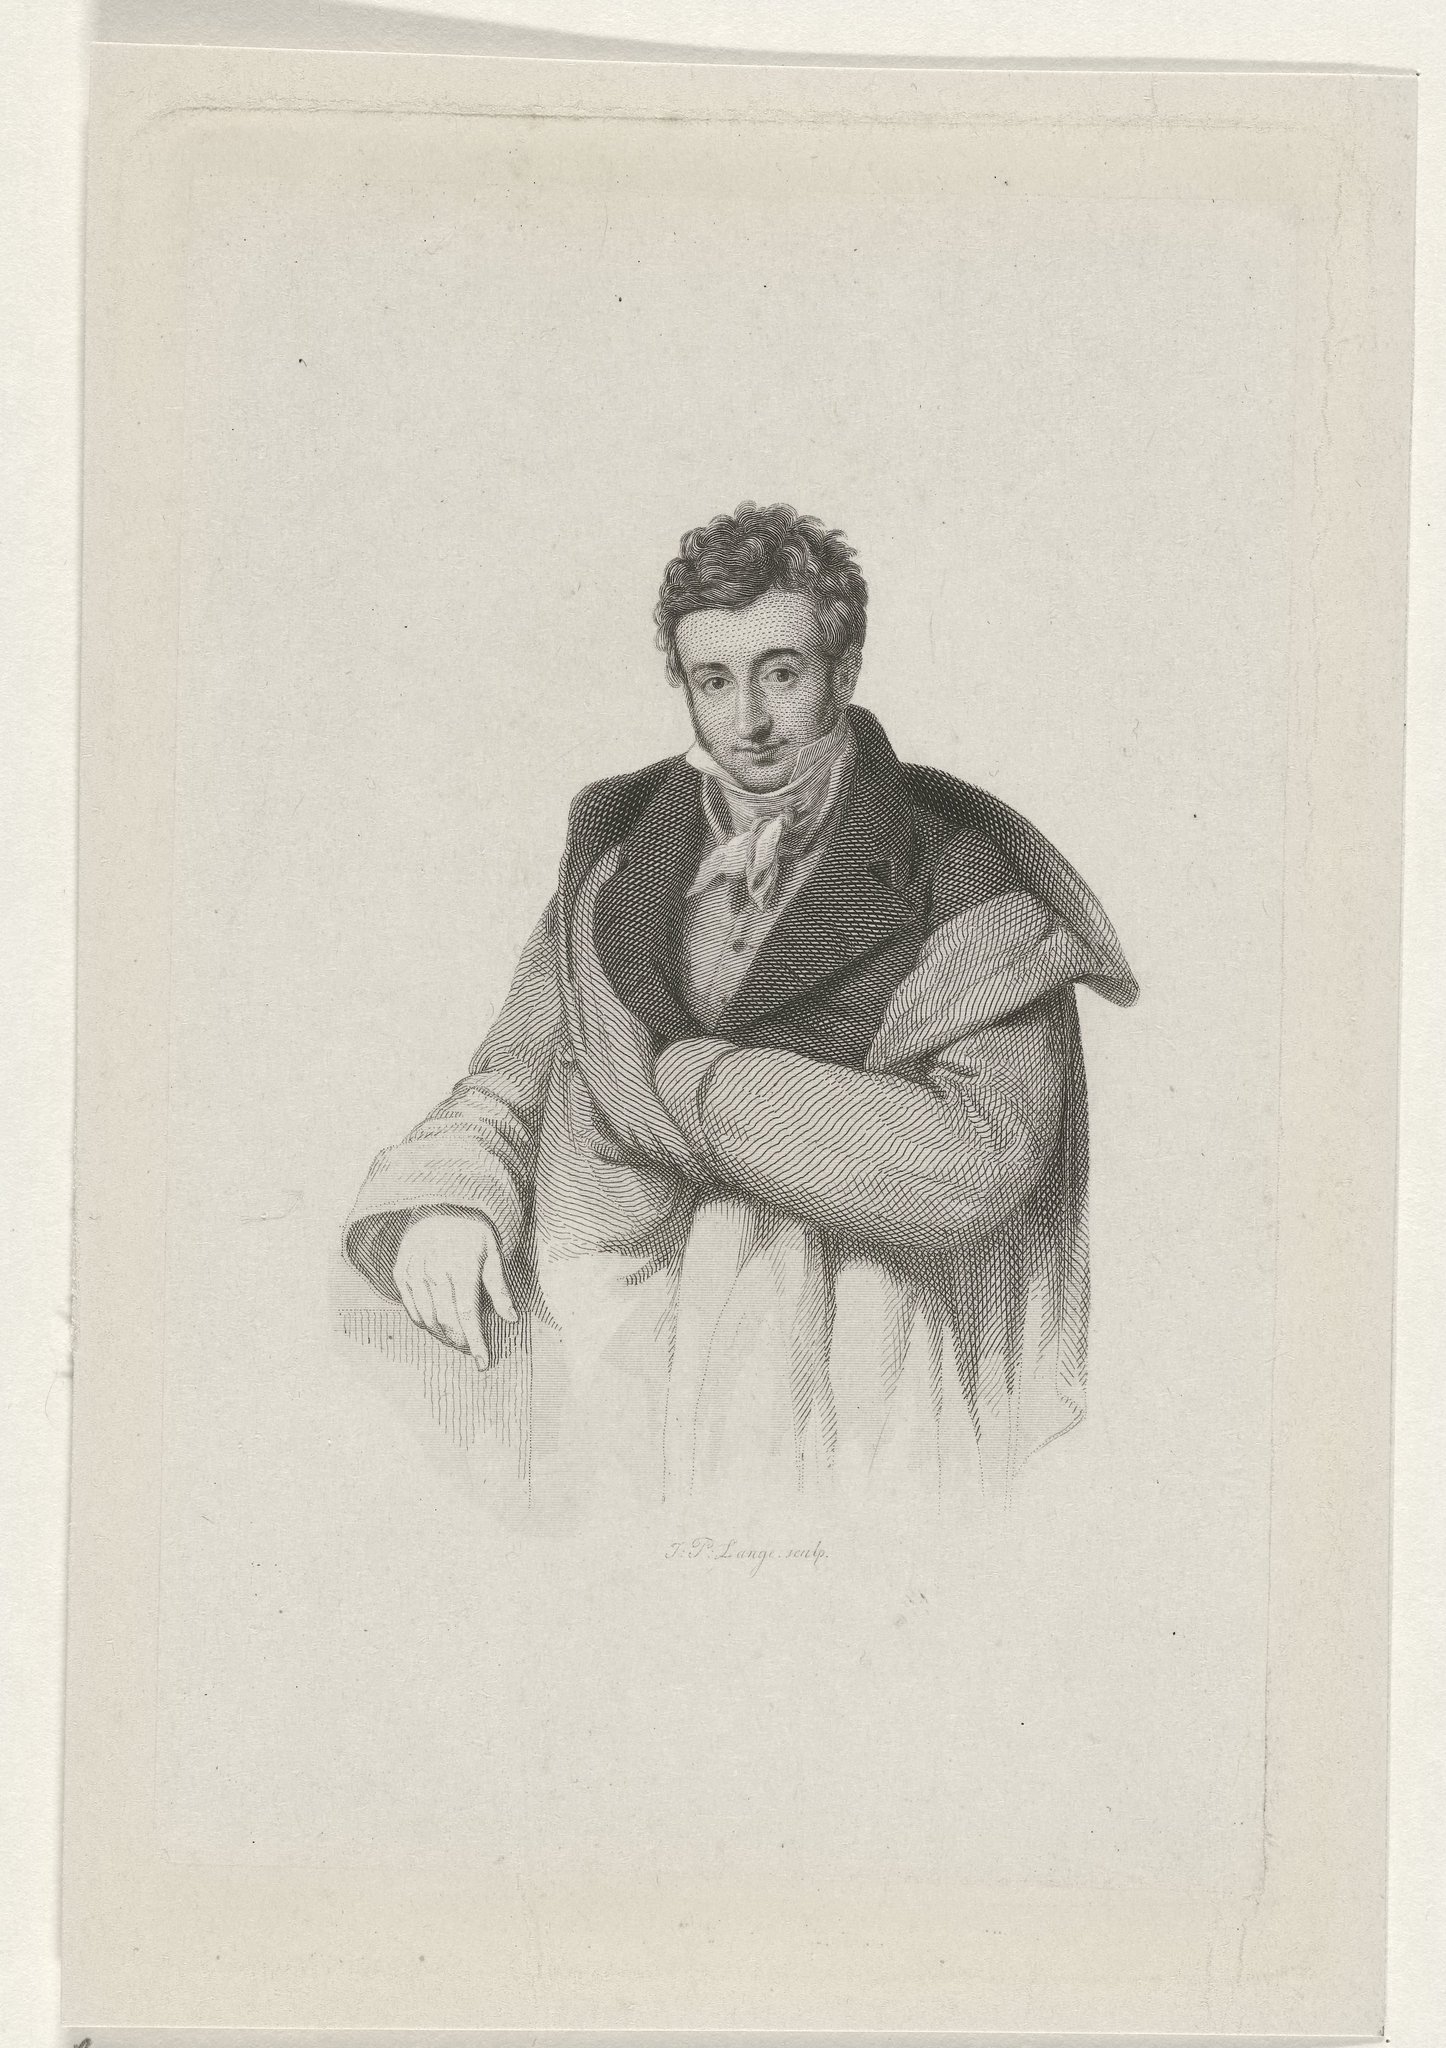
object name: print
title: Portret van Paulus Joseph Gabriël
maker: johannes philippus lange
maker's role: print maker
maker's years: 1810-1849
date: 1820-1849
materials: paper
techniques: engraving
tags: amsterdam, painter, sculptor, paulus joseph gabriël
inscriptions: collector's mark: Lugt 2228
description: Portret ten halven lijve van voren van schilder en beeldhouwer Paulus Joseph Gabriël, de linkerhand in zijn binnenzak gestoken.